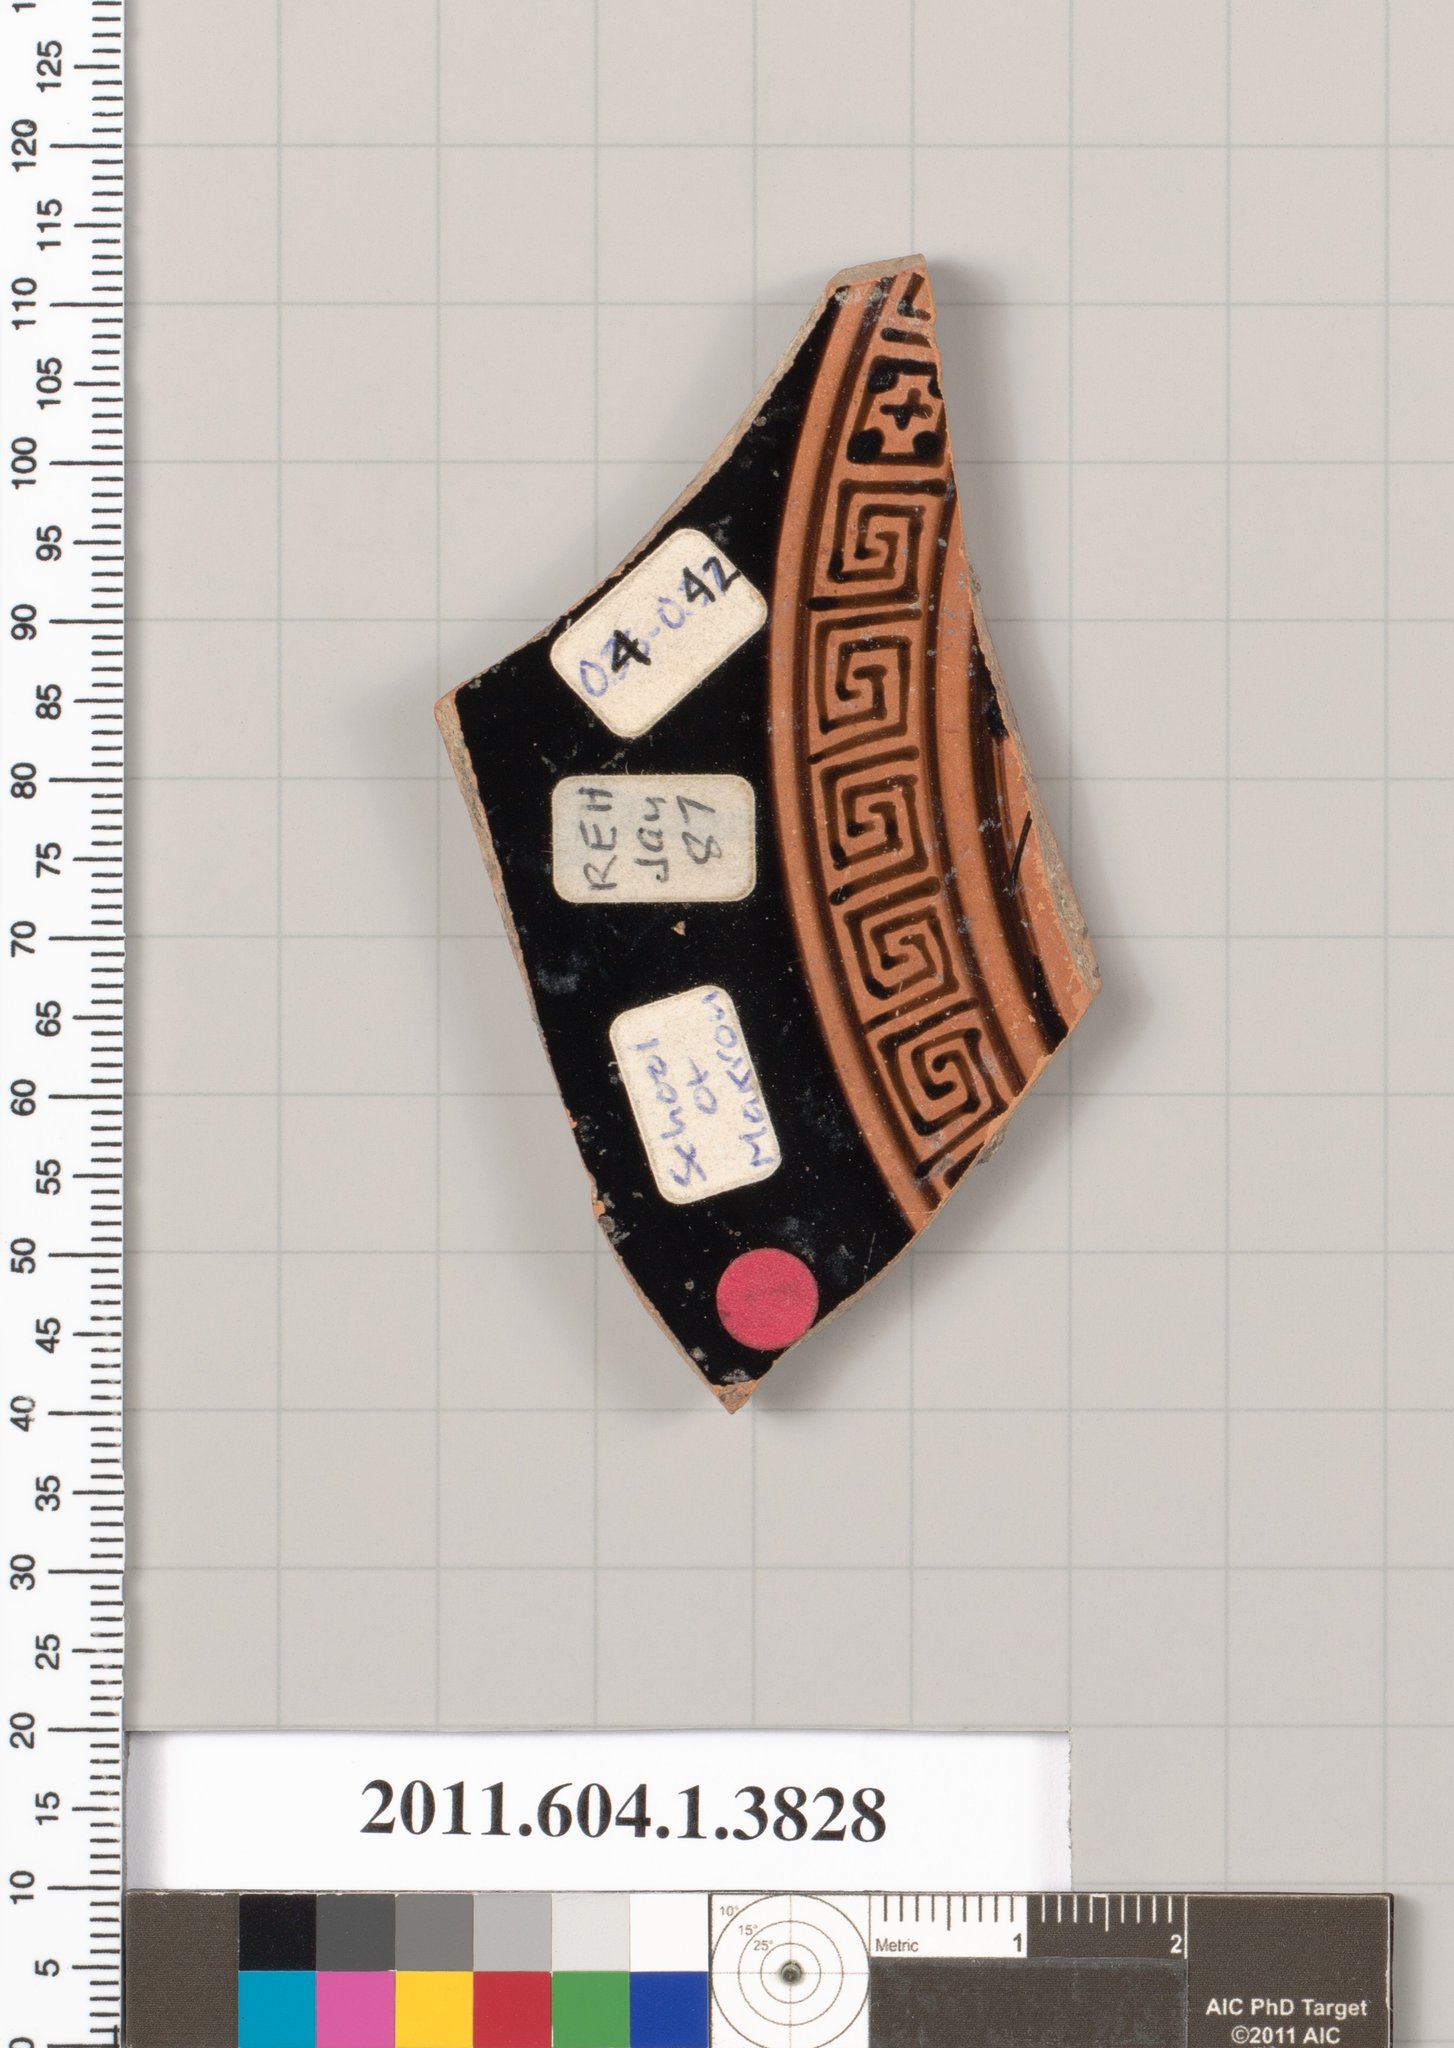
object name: kylix fragment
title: Terracotta fragment of a kylix (drinking cup)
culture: greek, attic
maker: makron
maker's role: artist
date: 490-470 BCE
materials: terracotta